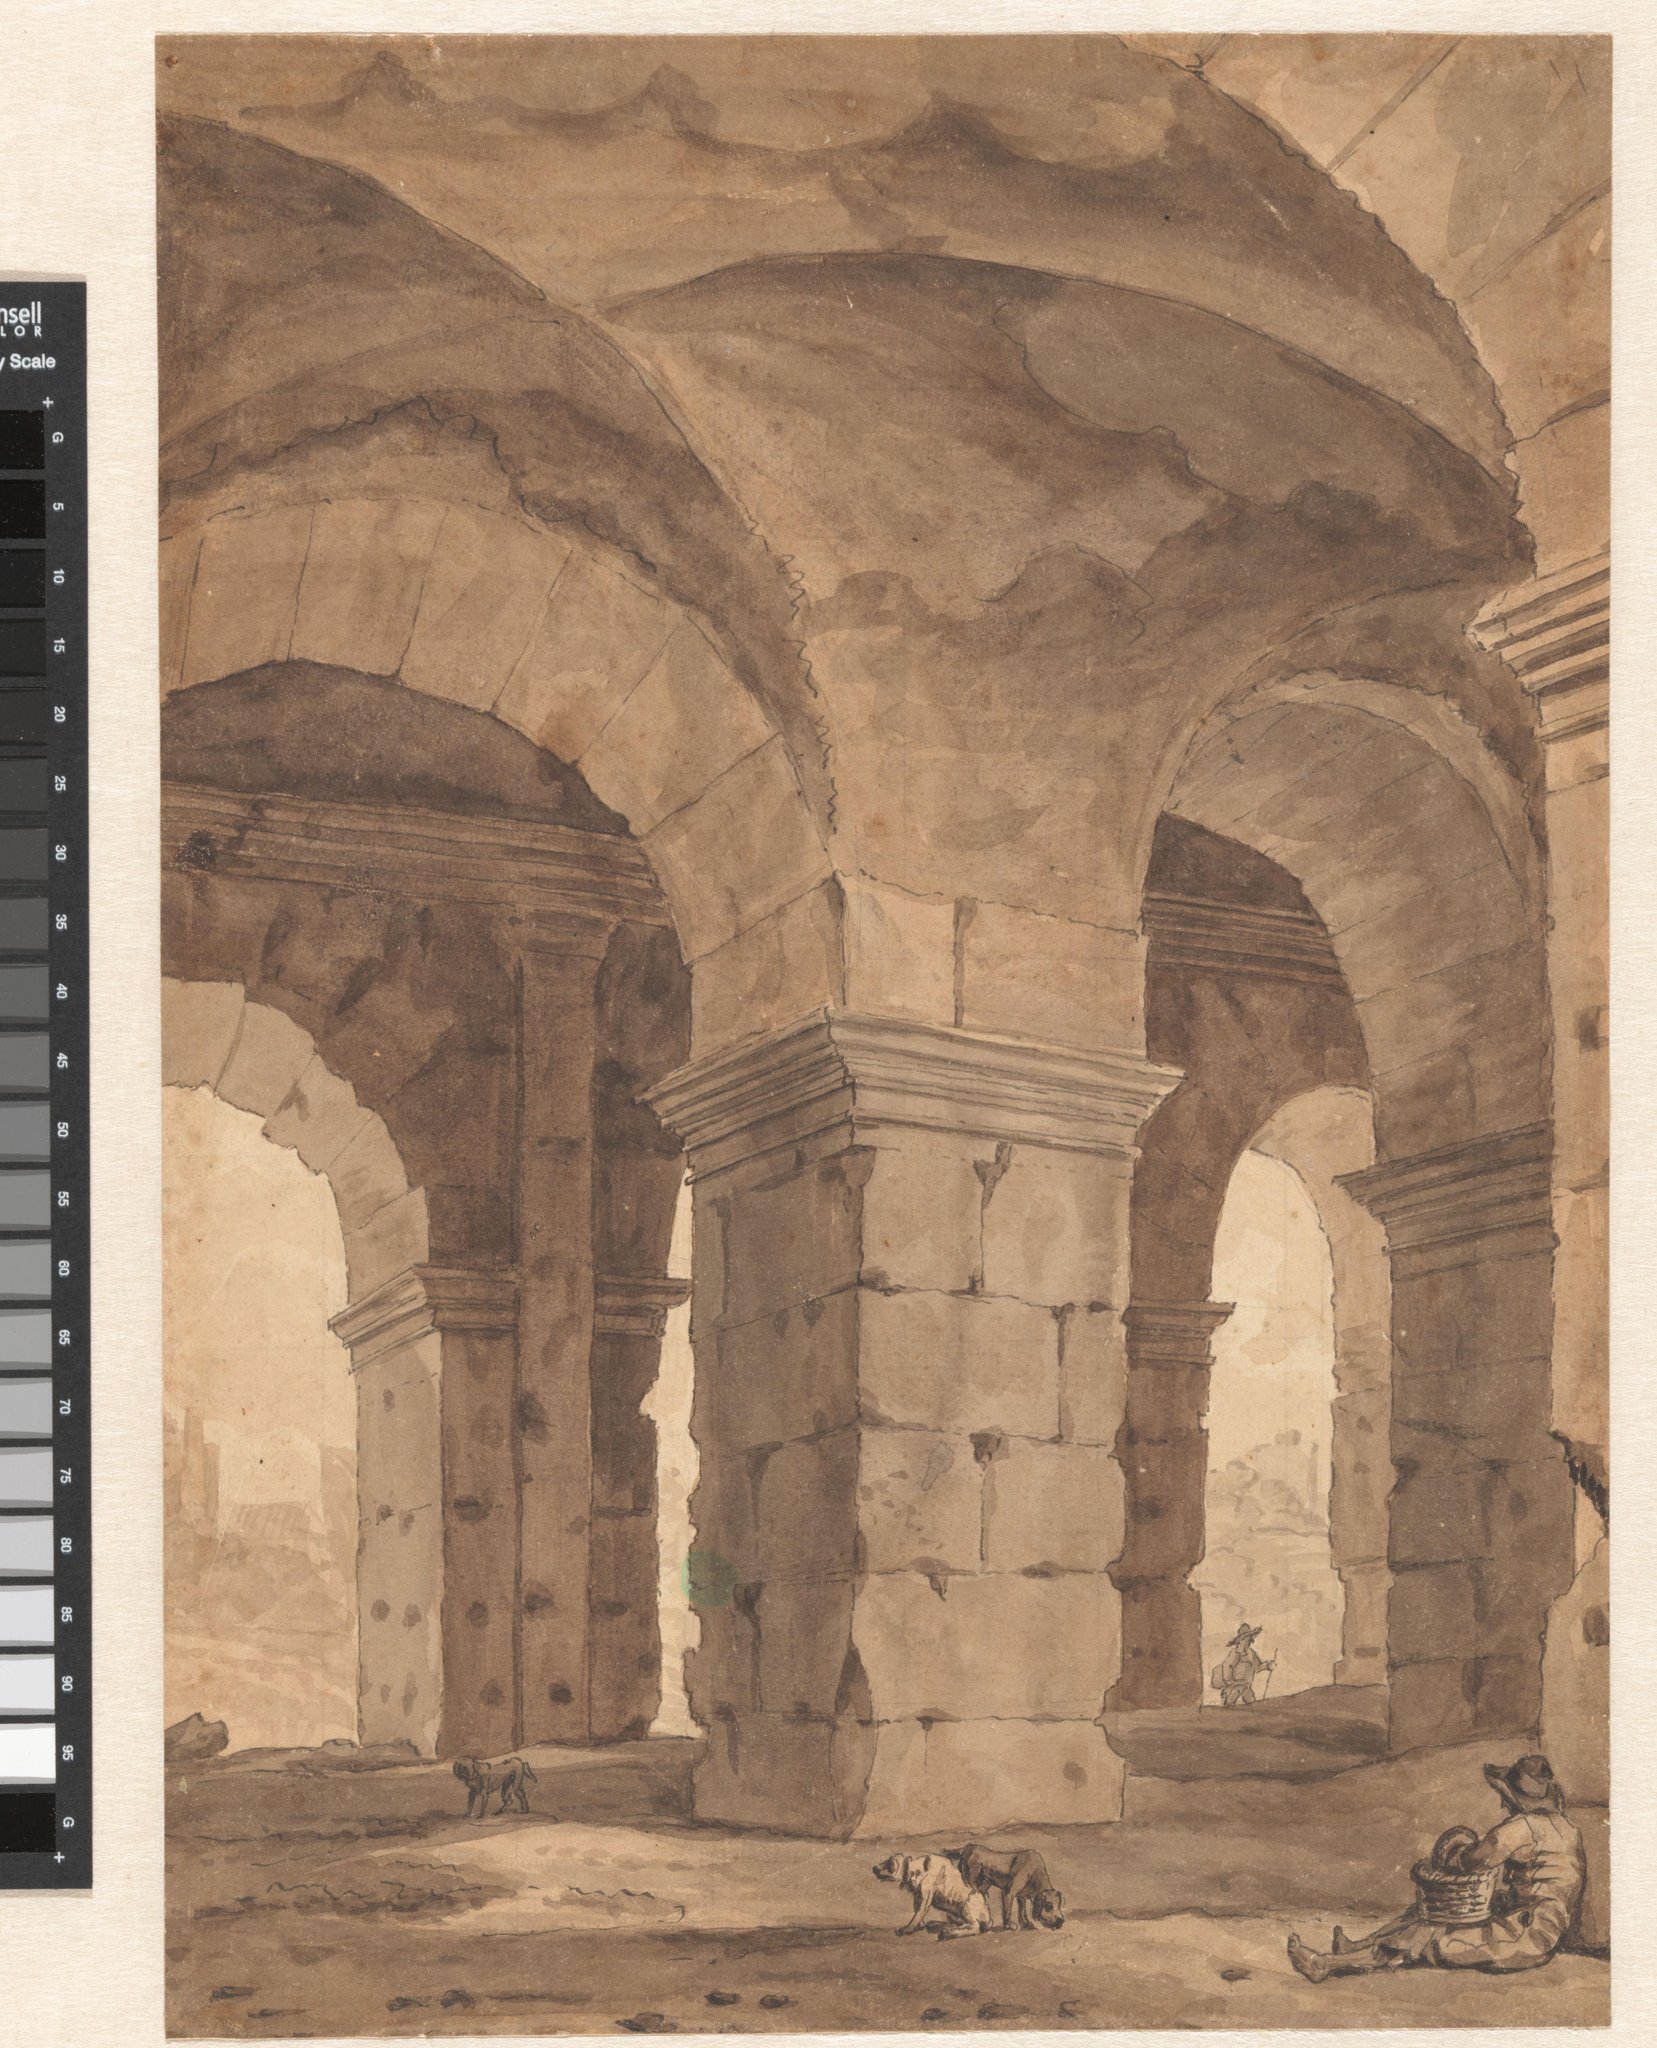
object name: drawing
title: Onder de bogen van het Colosseum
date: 1762-1781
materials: chalk, ink, paper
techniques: brush, pen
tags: vault ~ architecture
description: Tekening uit een groep tekeningen van landschappen en stadsgezichten in Italië (Rome, Tivoli, Civita Castellana en Pozzuoli).